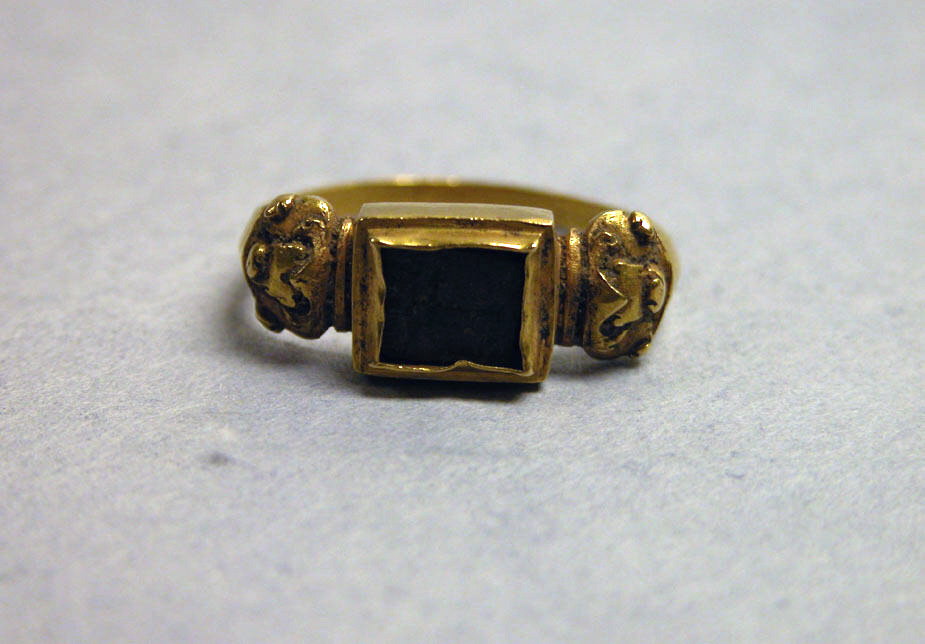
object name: ring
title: Ring with Inset Rectangular Cut Stone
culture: indonesian, javanese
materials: gold, stone